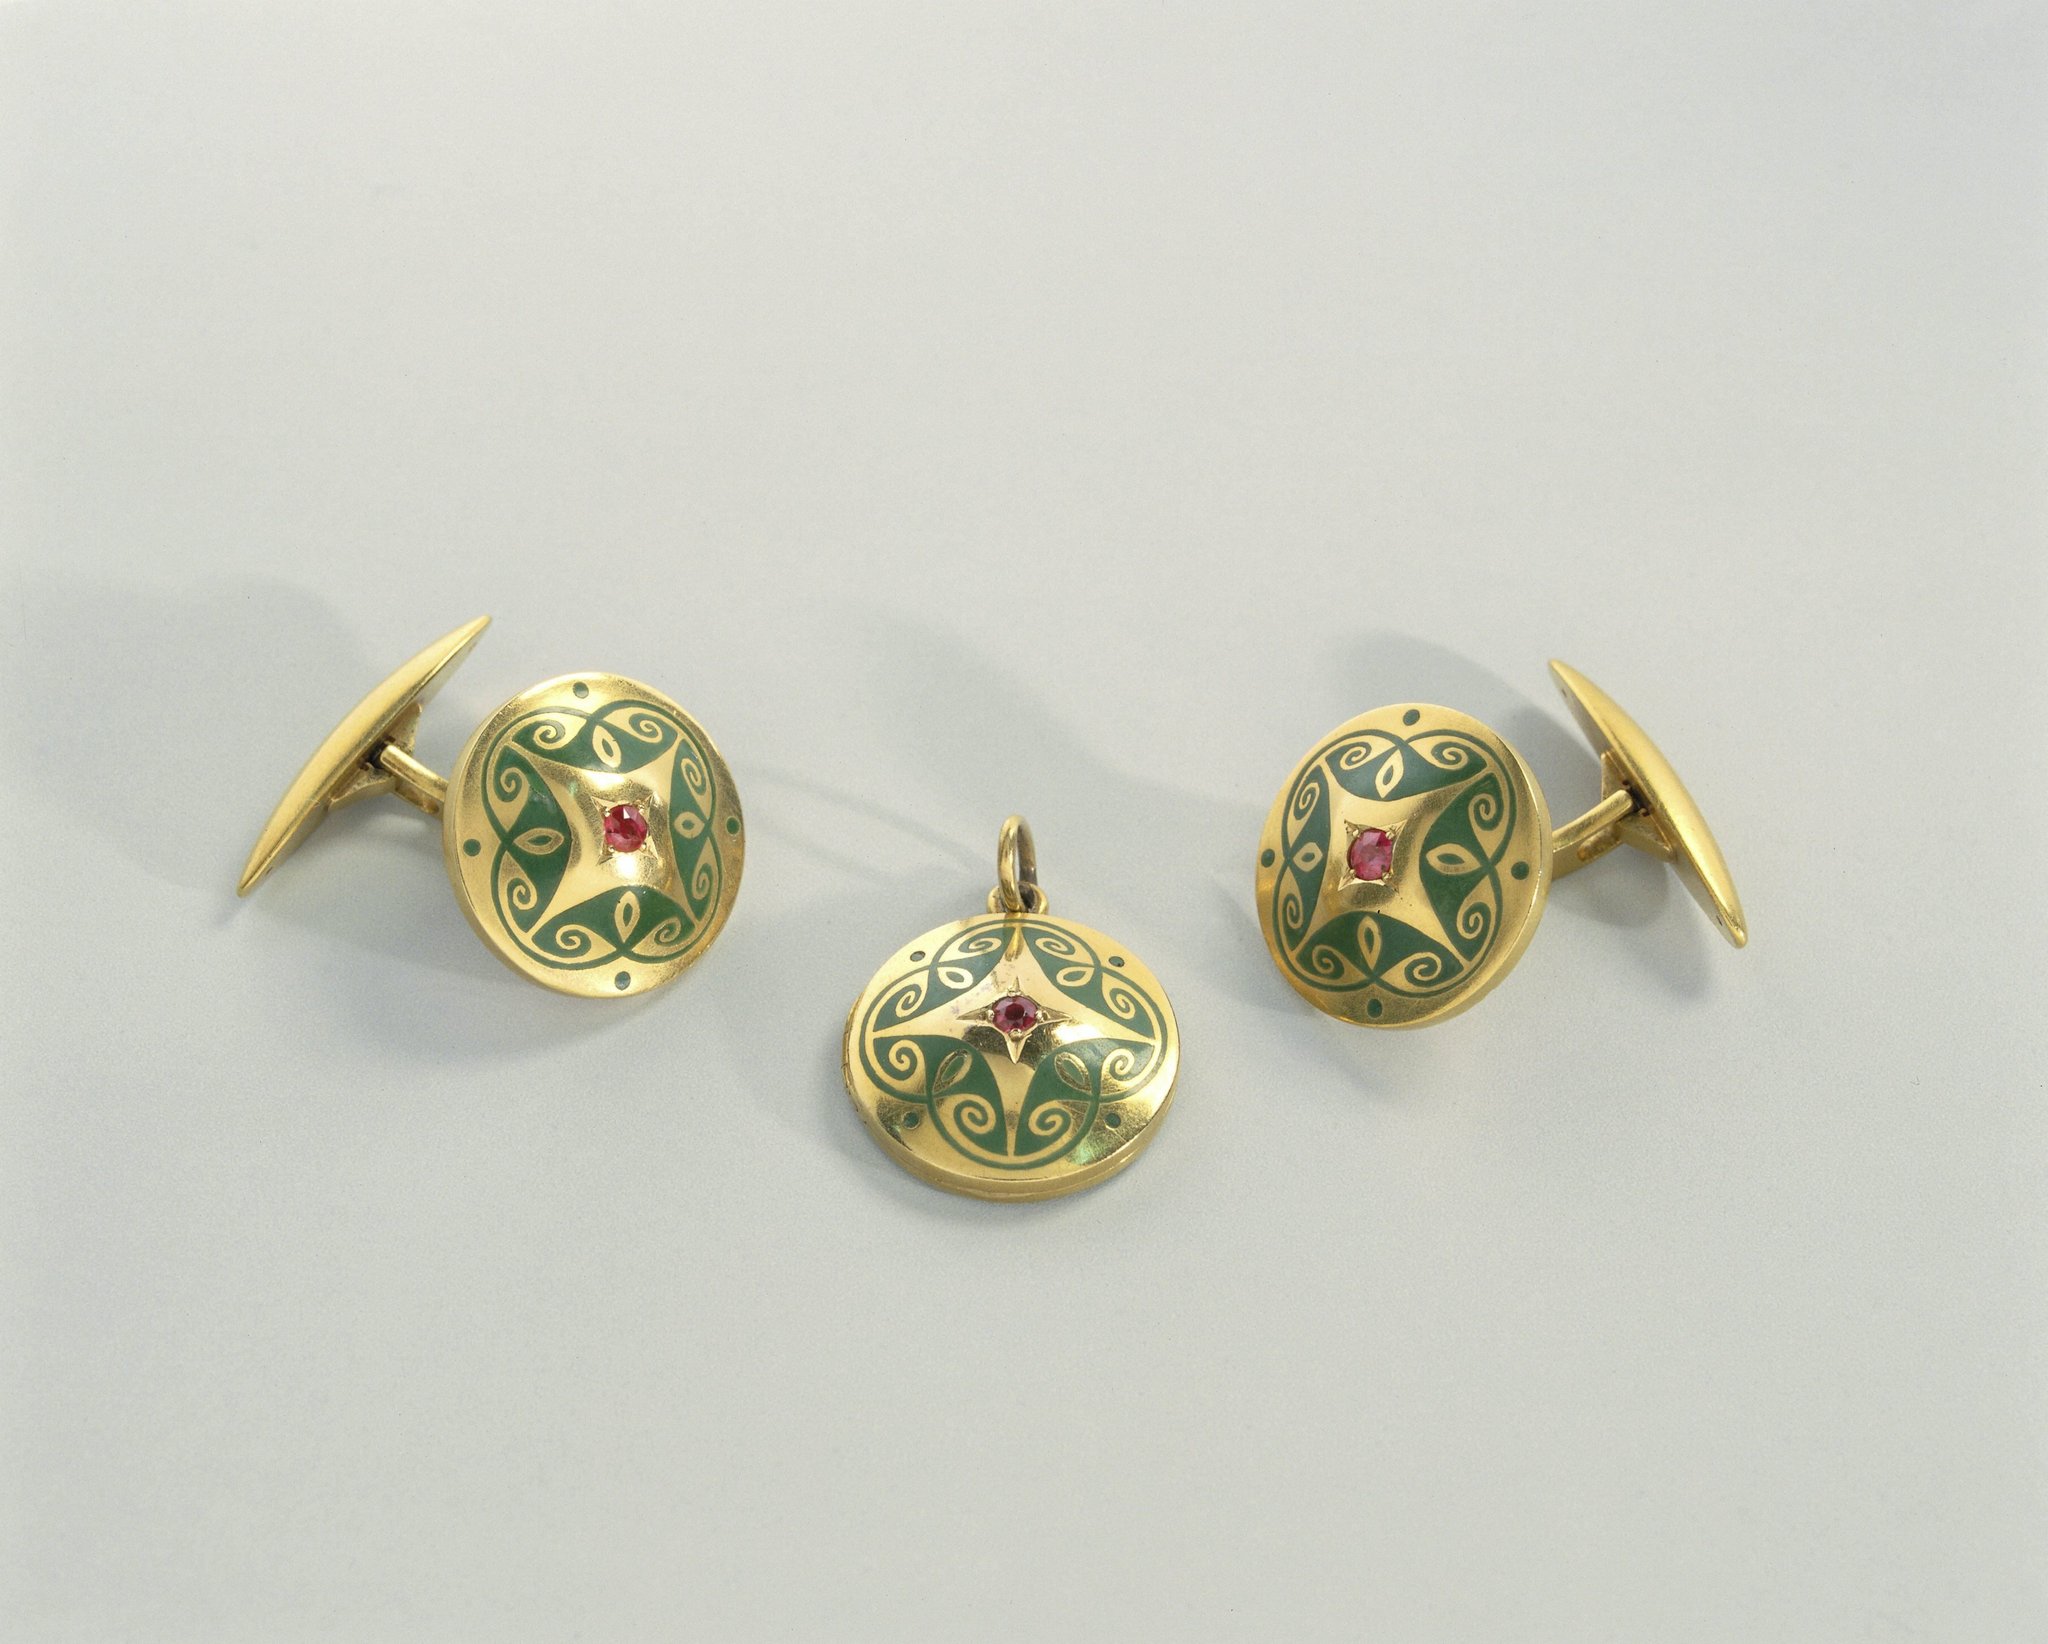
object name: pendant jewelry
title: Hanger van goud en groen email, met een robijn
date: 1908-1911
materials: gold, gemstone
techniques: enameling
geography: amsterdam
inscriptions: alloy mark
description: Jewellery. Gold, silver, enamel and semi-precious stones. Amsterdam, c. 1908 - 1911, by L.W. van Kooten, designed by Bert Nienhuis. Given by the Prins Bernhard Fonds, 1980.